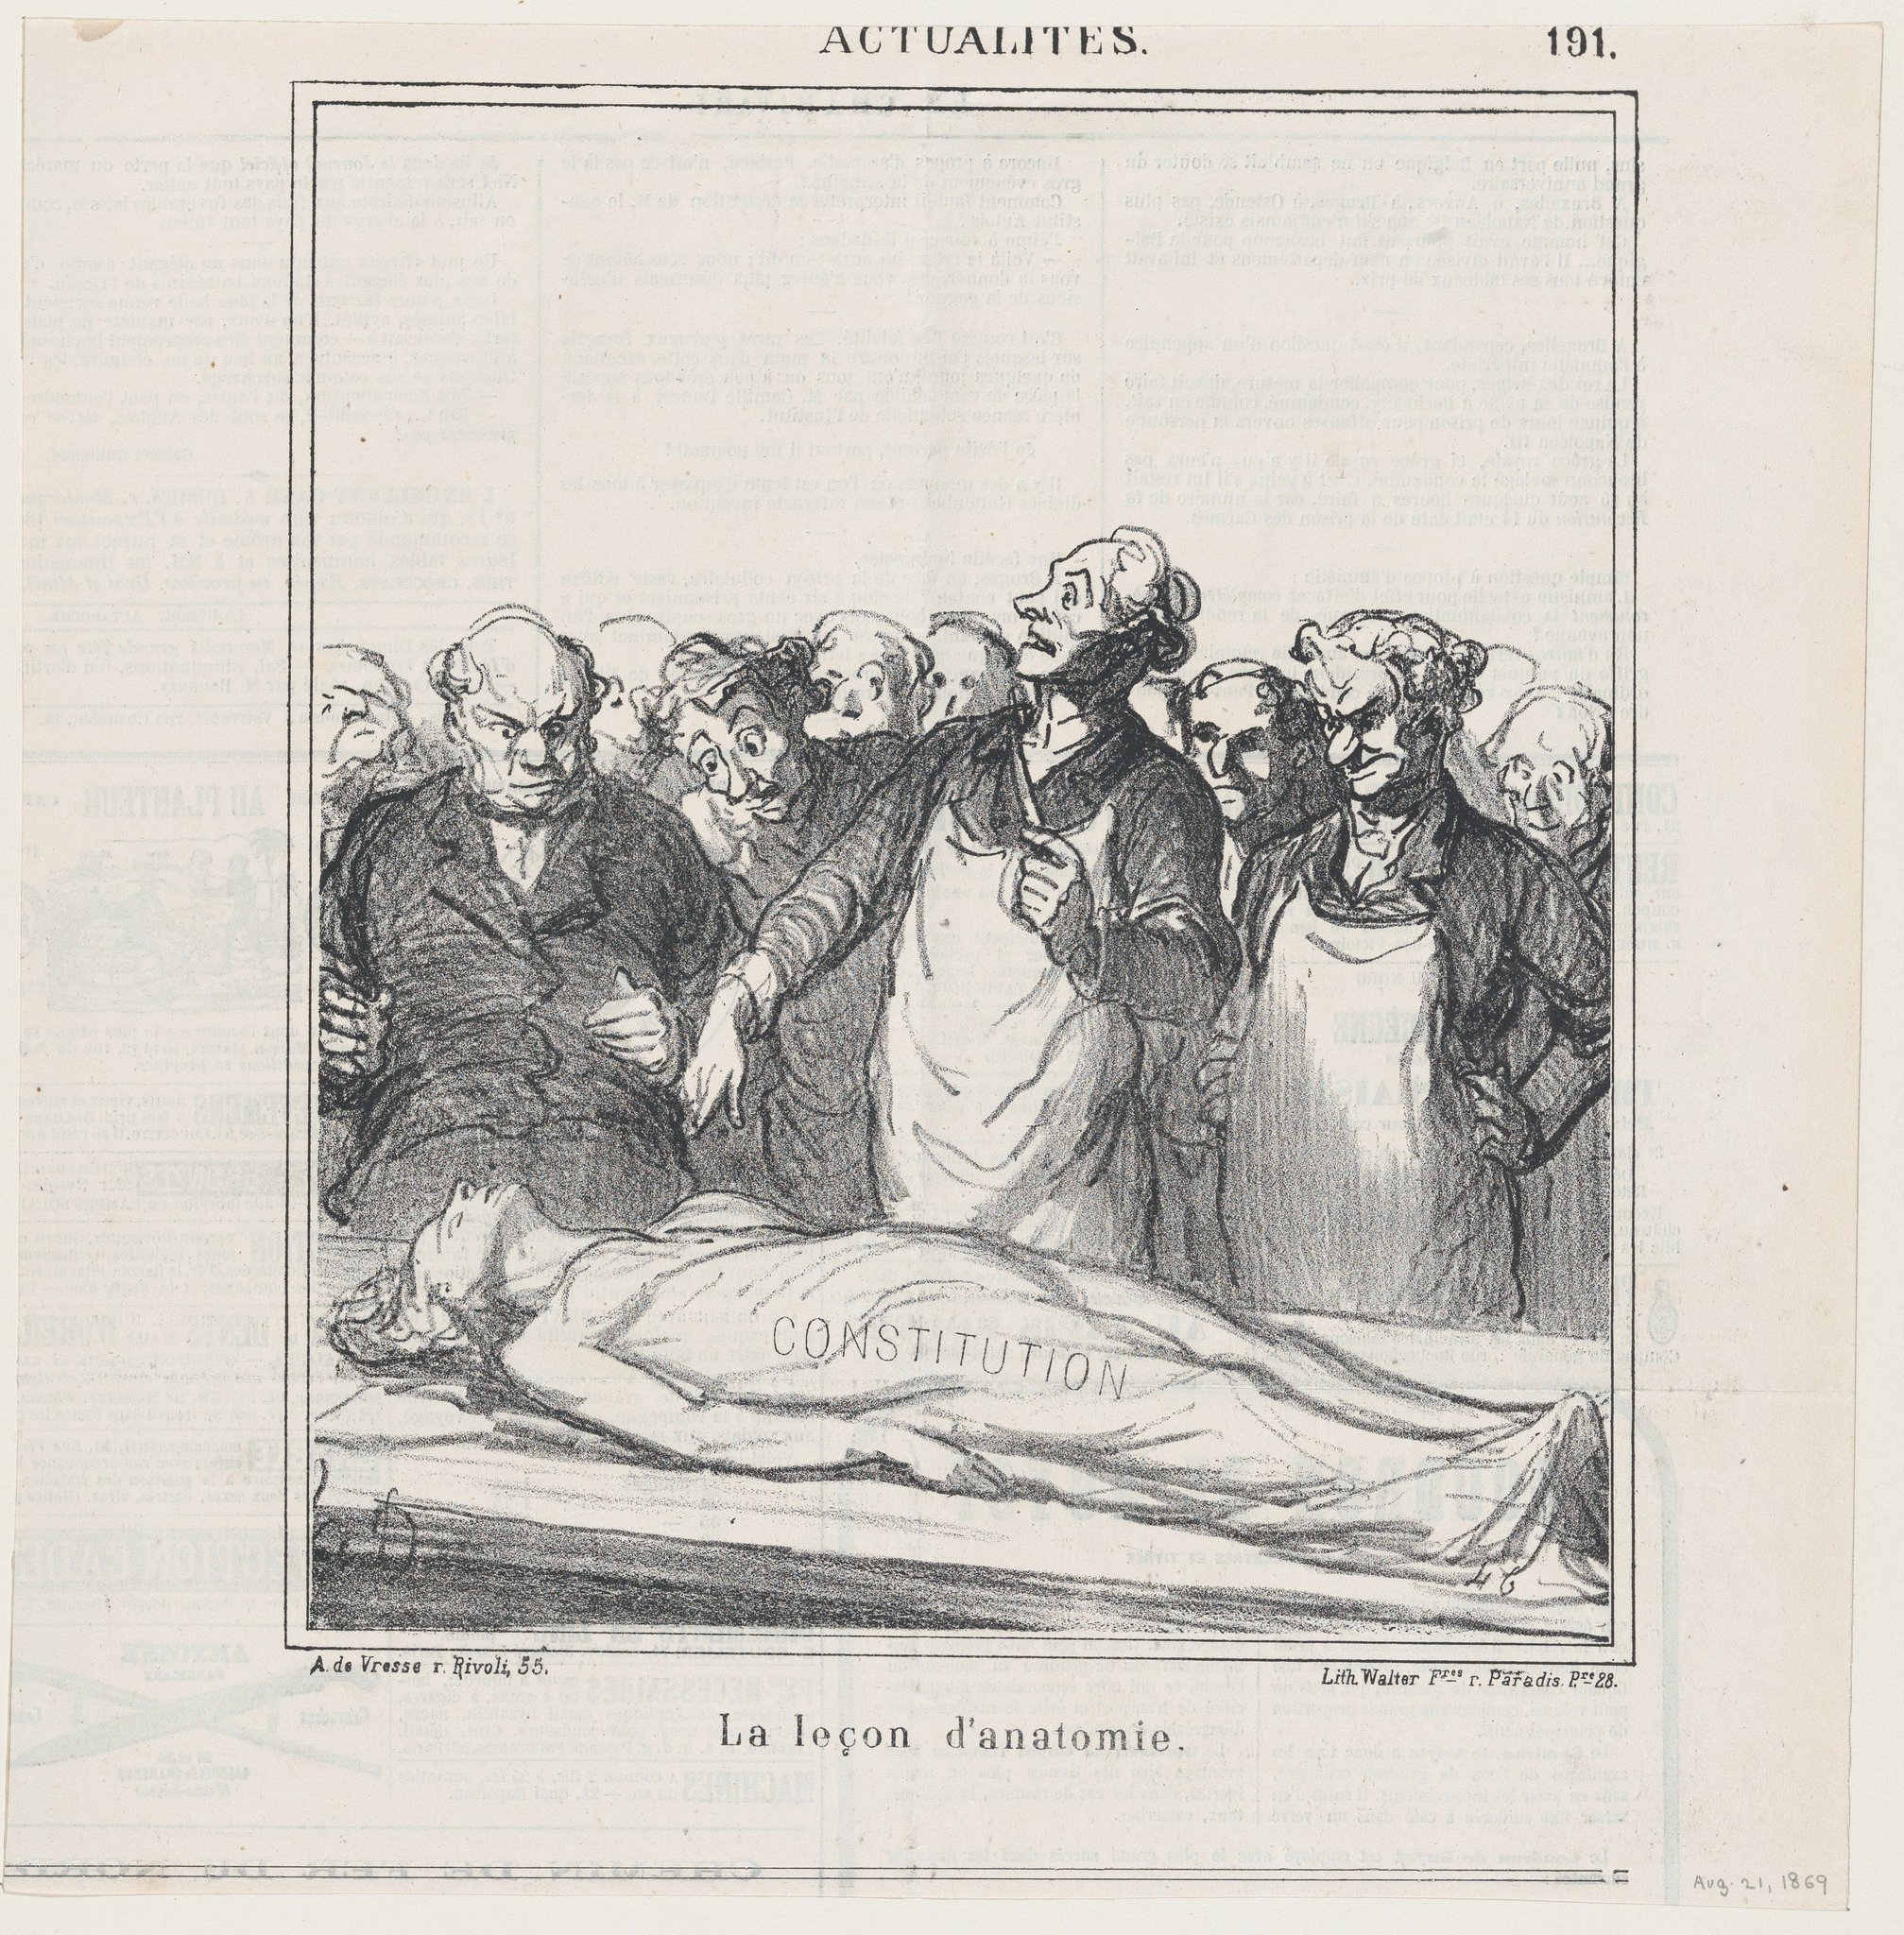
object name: print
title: An anatomy lesson, from 'News of the day,' published in Le Charivari, August 21, 1869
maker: honoré daumier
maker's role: artist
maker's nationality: french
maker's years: 1808-1879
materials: paper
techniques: lithograph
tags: human anatomy,satire,men